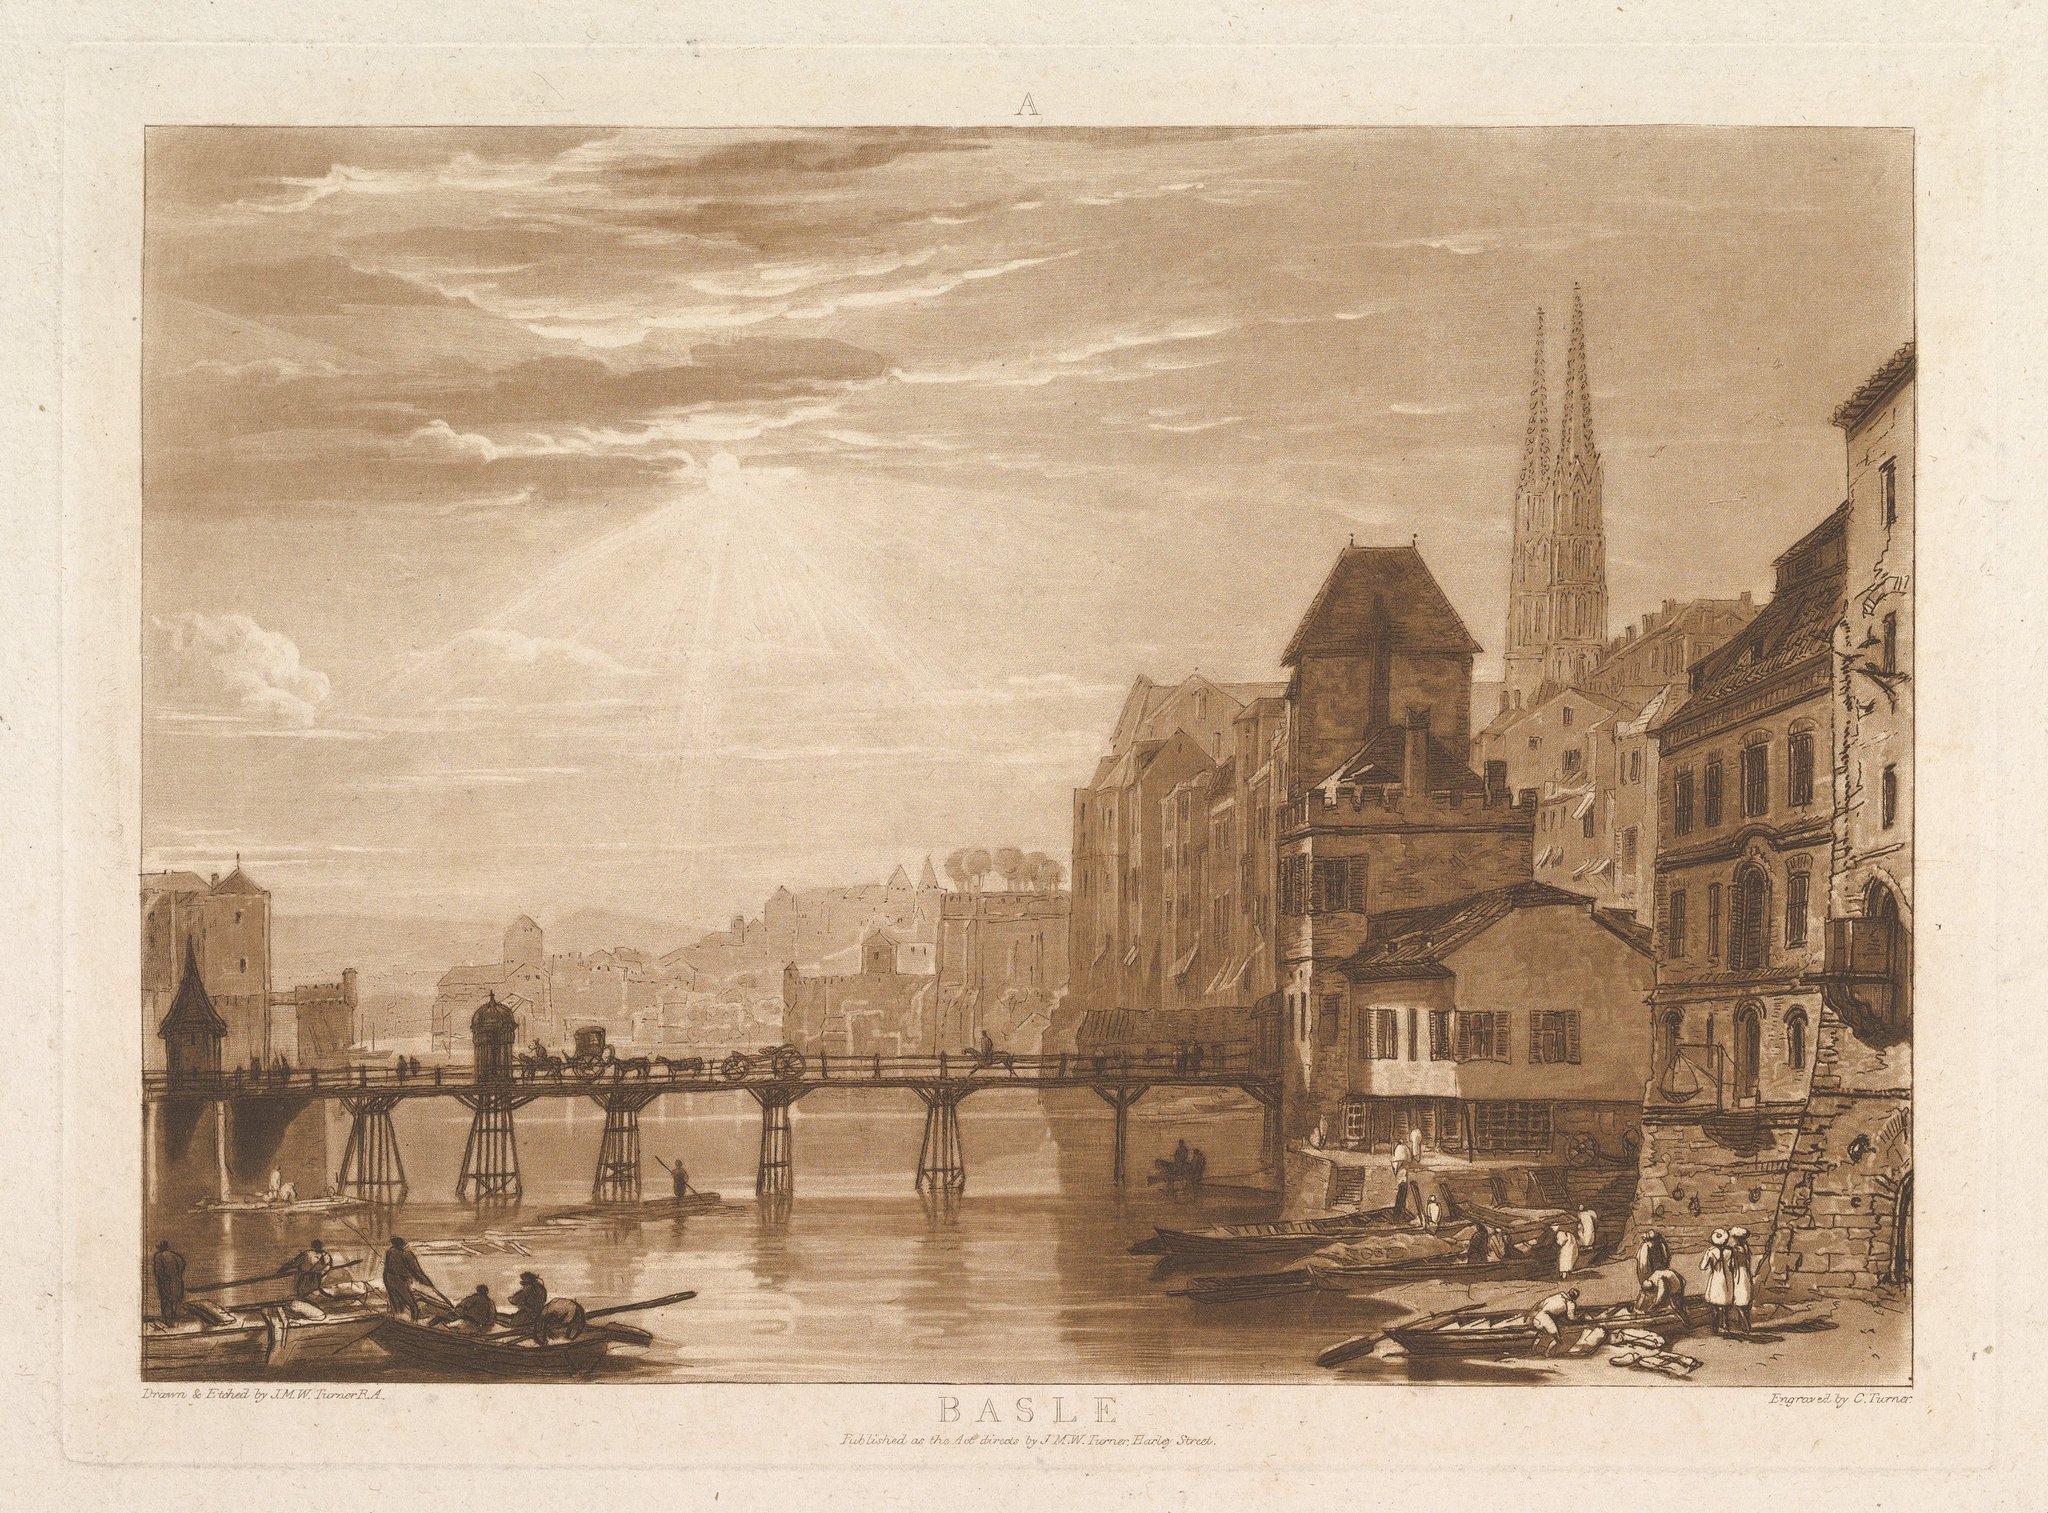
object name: print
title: Basle, part I, plate 5 from "Liber Studiorum"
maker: joseph mallord william turner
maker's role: artist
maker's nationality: british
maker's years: 1775-1851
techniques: etching, mezzotint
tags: buildings,cities,bridges,boats